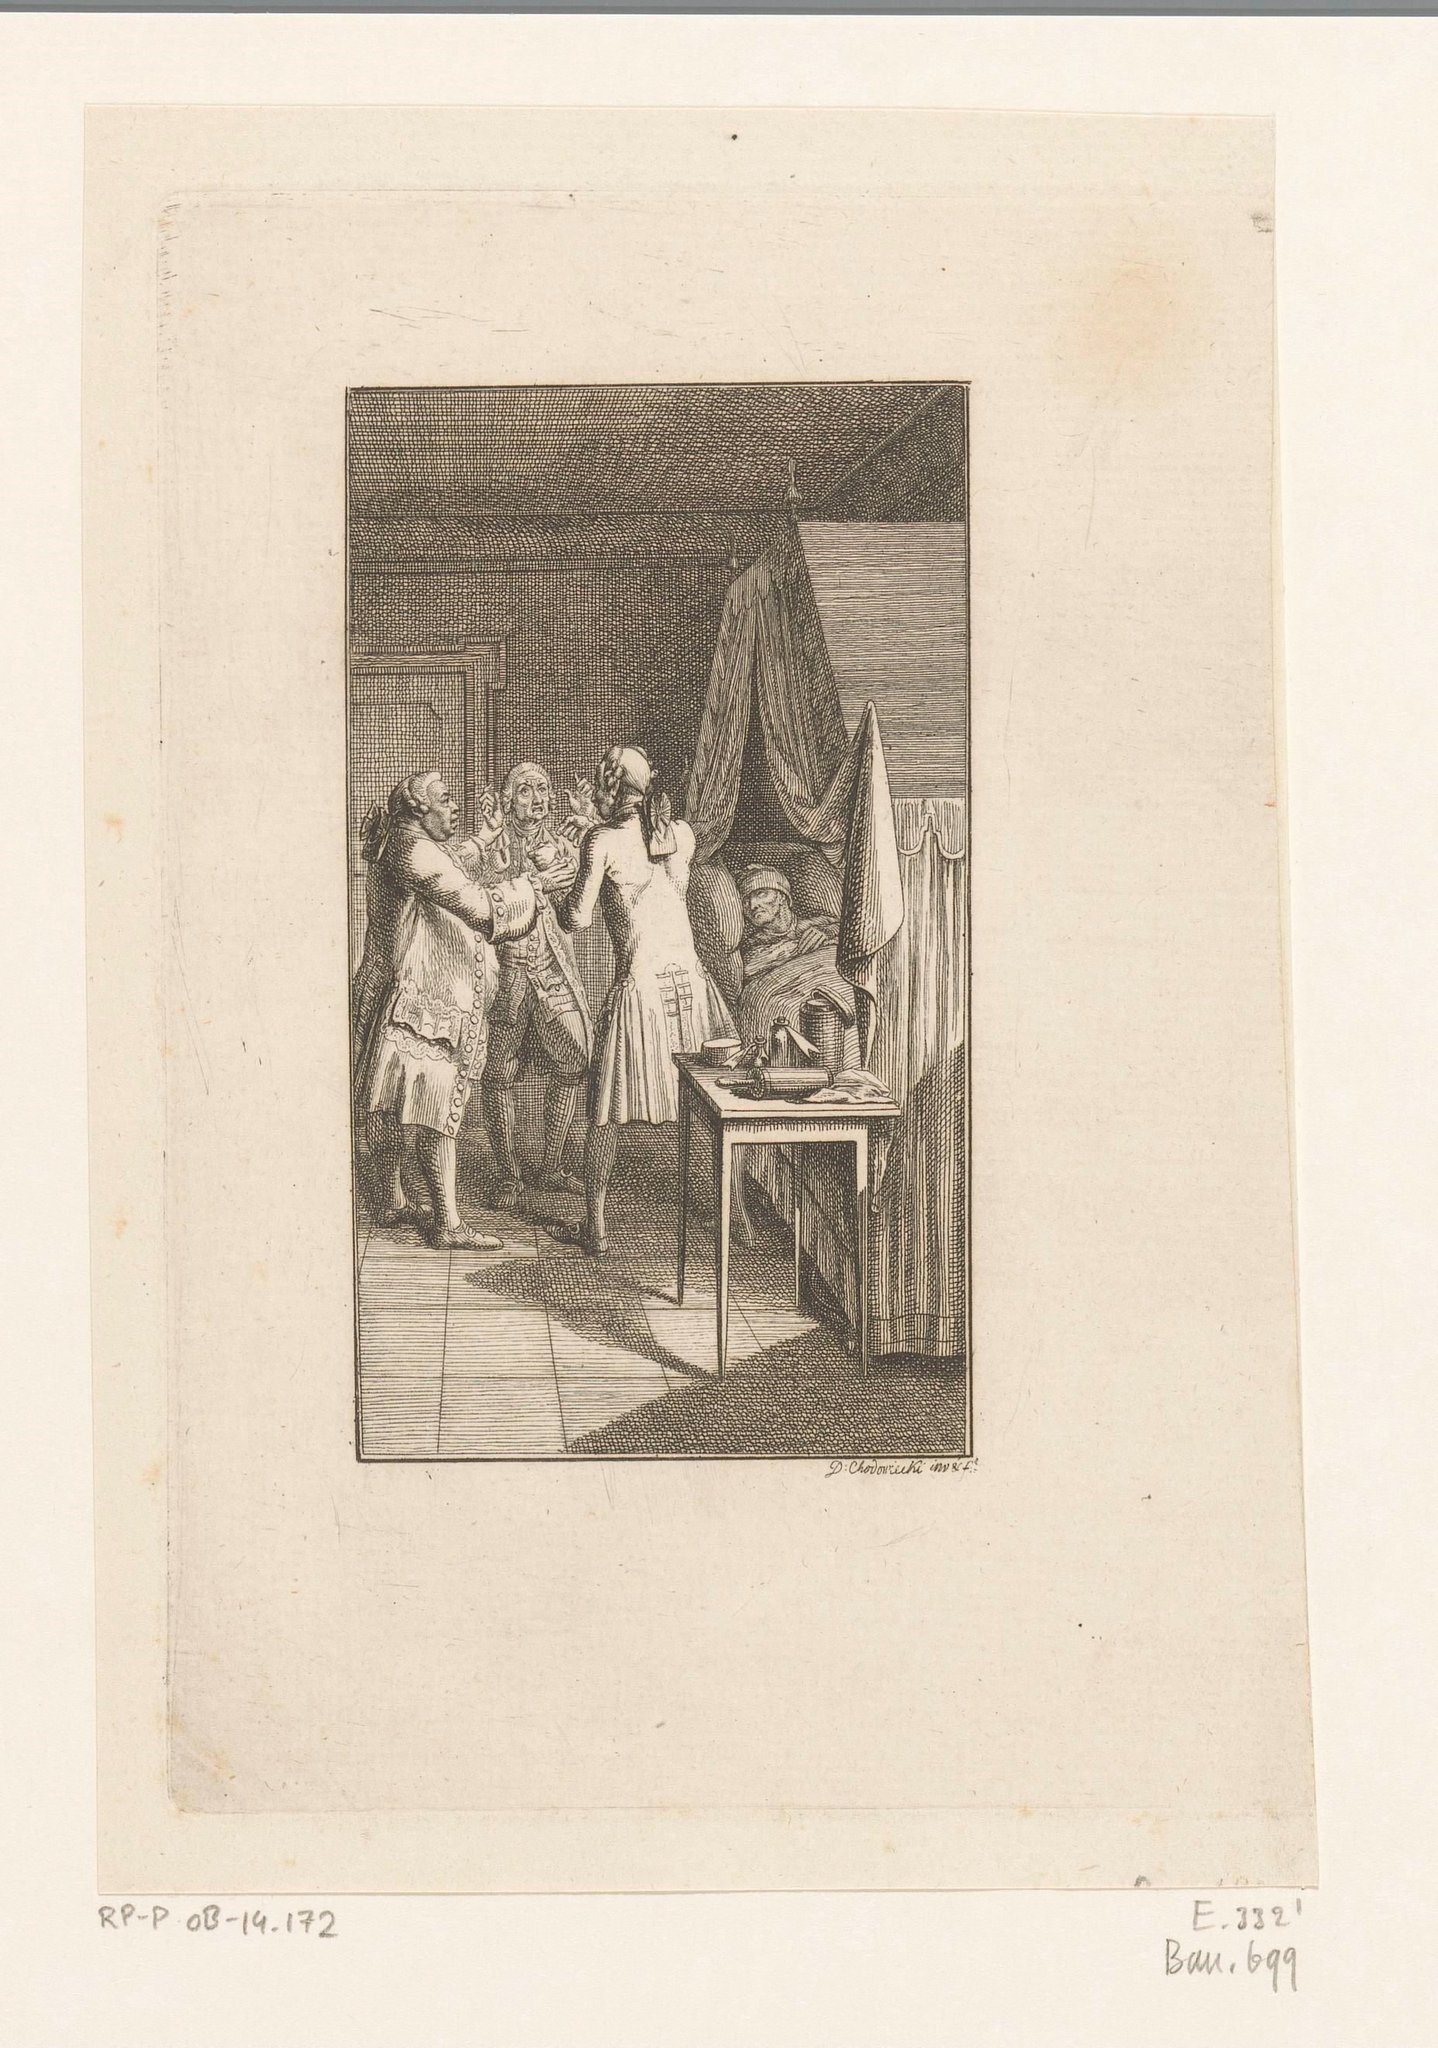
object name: print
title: Drie artsen discussiëren naast het bed van een zieke man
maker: daniel nikolaus chodowiecki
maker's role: draughtsman, print maker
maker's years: 1726-1801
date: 1779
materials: paper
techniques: etching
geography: berlin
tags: sick-bed, physician, doctor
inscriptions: collector's mark: Lugt 2228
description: Prent ook gebruikt in: Fritze, Johann Gottlieb. Medicinische Annalen für Ärtze und Gesundheitsliebende, vom Herbstmonath 1779 bis dahin 1780. Leipzig: Weygandsche Buchhandlung, 1781, dl. 1.